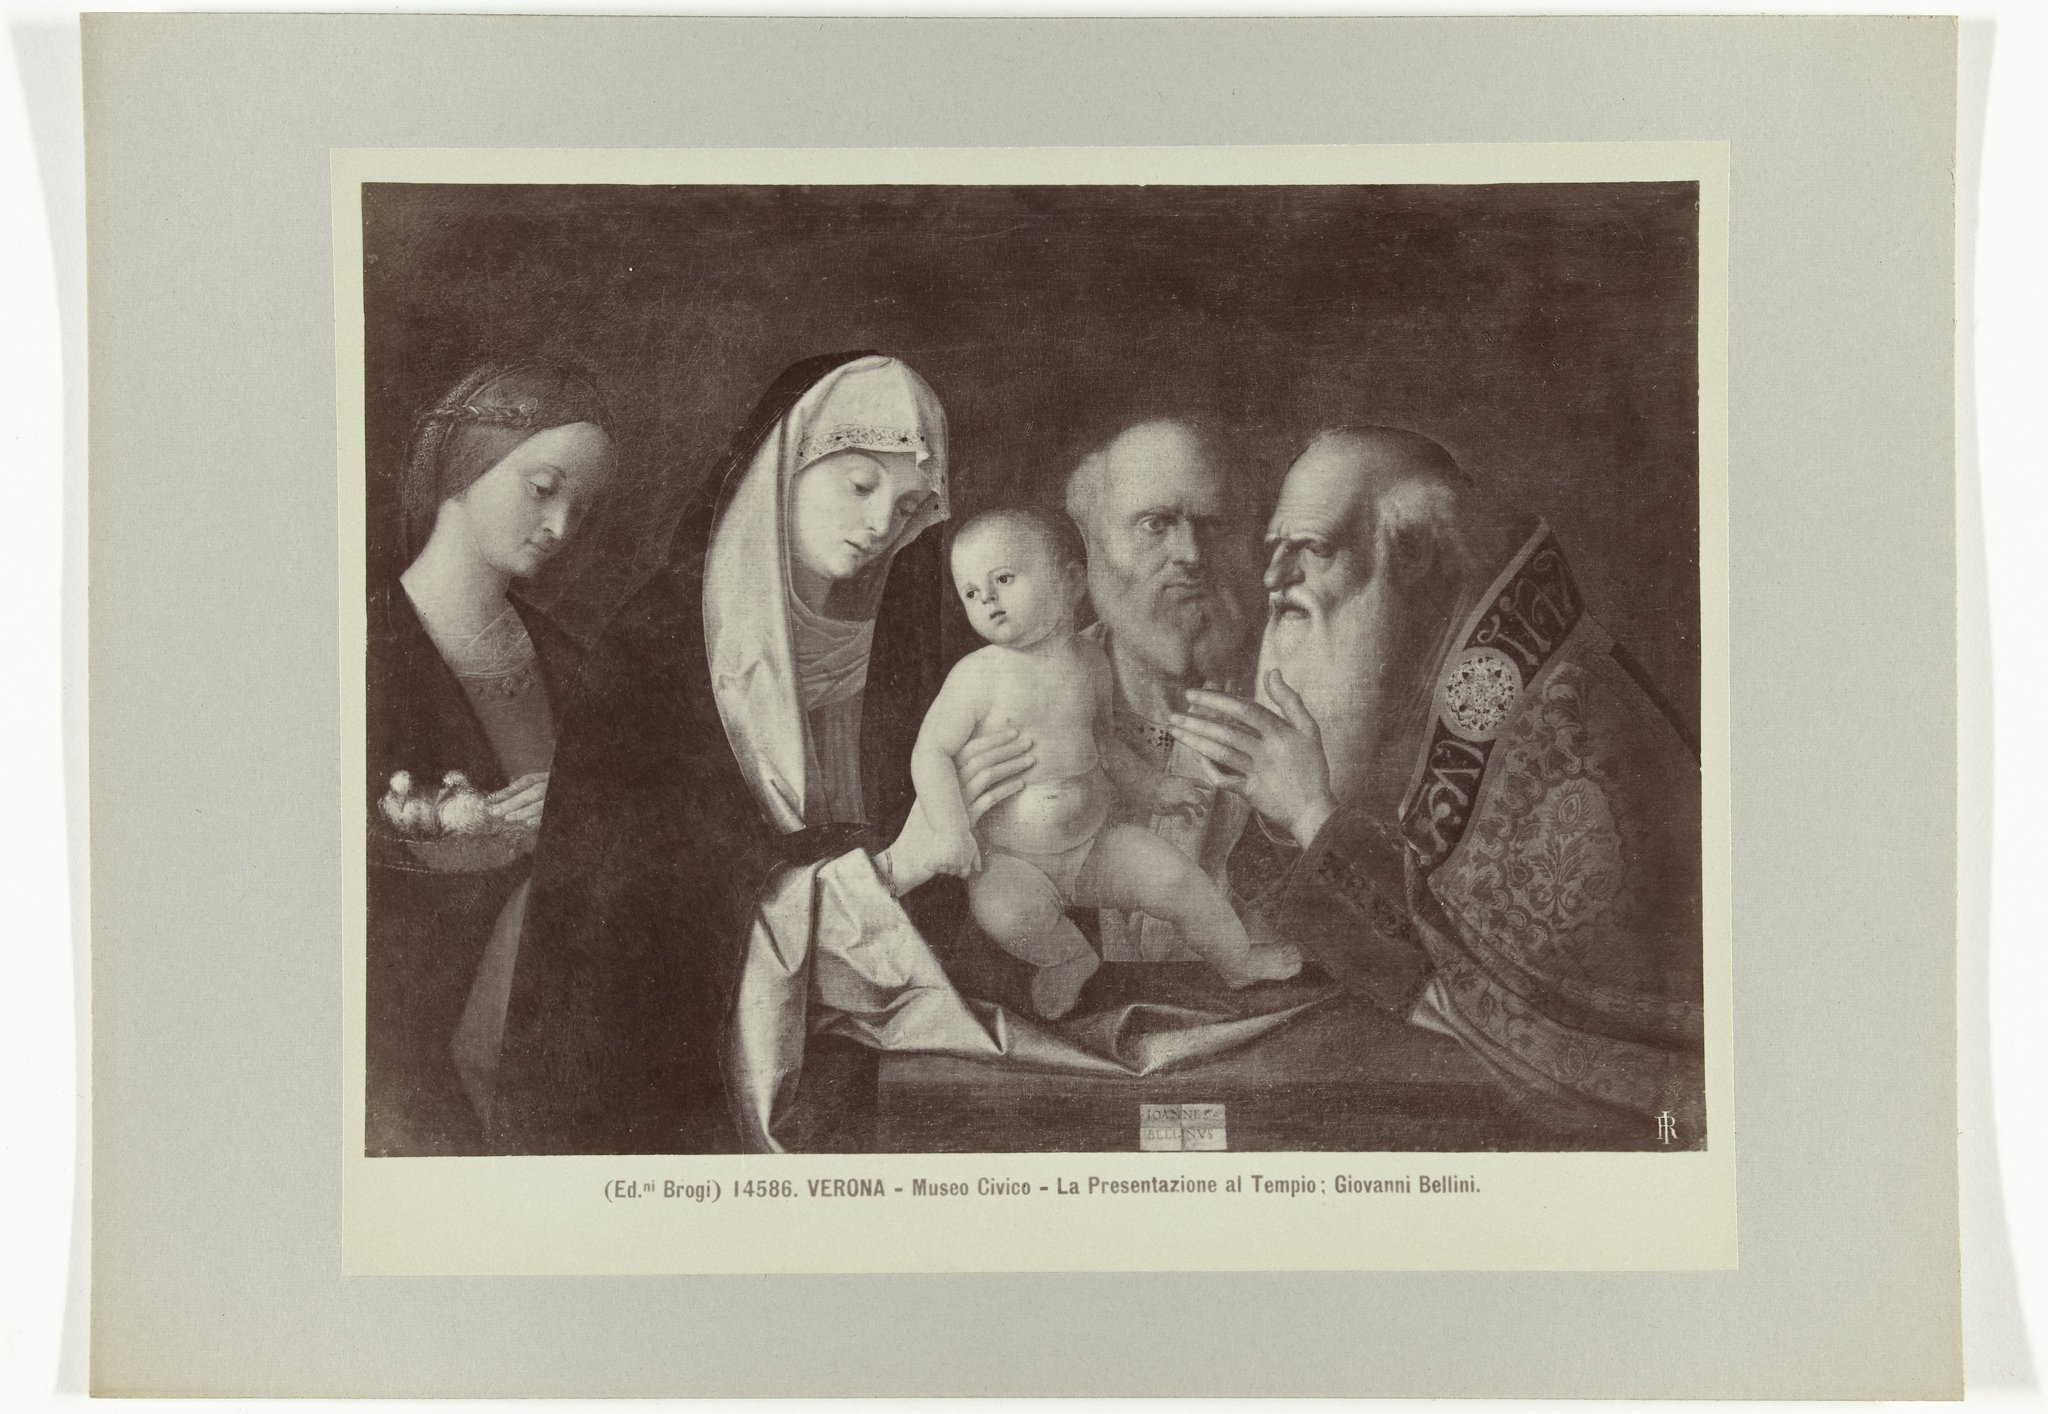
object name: photograph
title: Schilderij De presentatie in de Tempel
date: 1880-1904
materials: cardboard, paper, photographic support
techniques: albumen print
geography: florence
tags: presentation of the christ-child in the temple, usually simeon (and anna) present (luke 2:22-39), rome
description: Schilderij gemaakt door Giovanni Bellini.